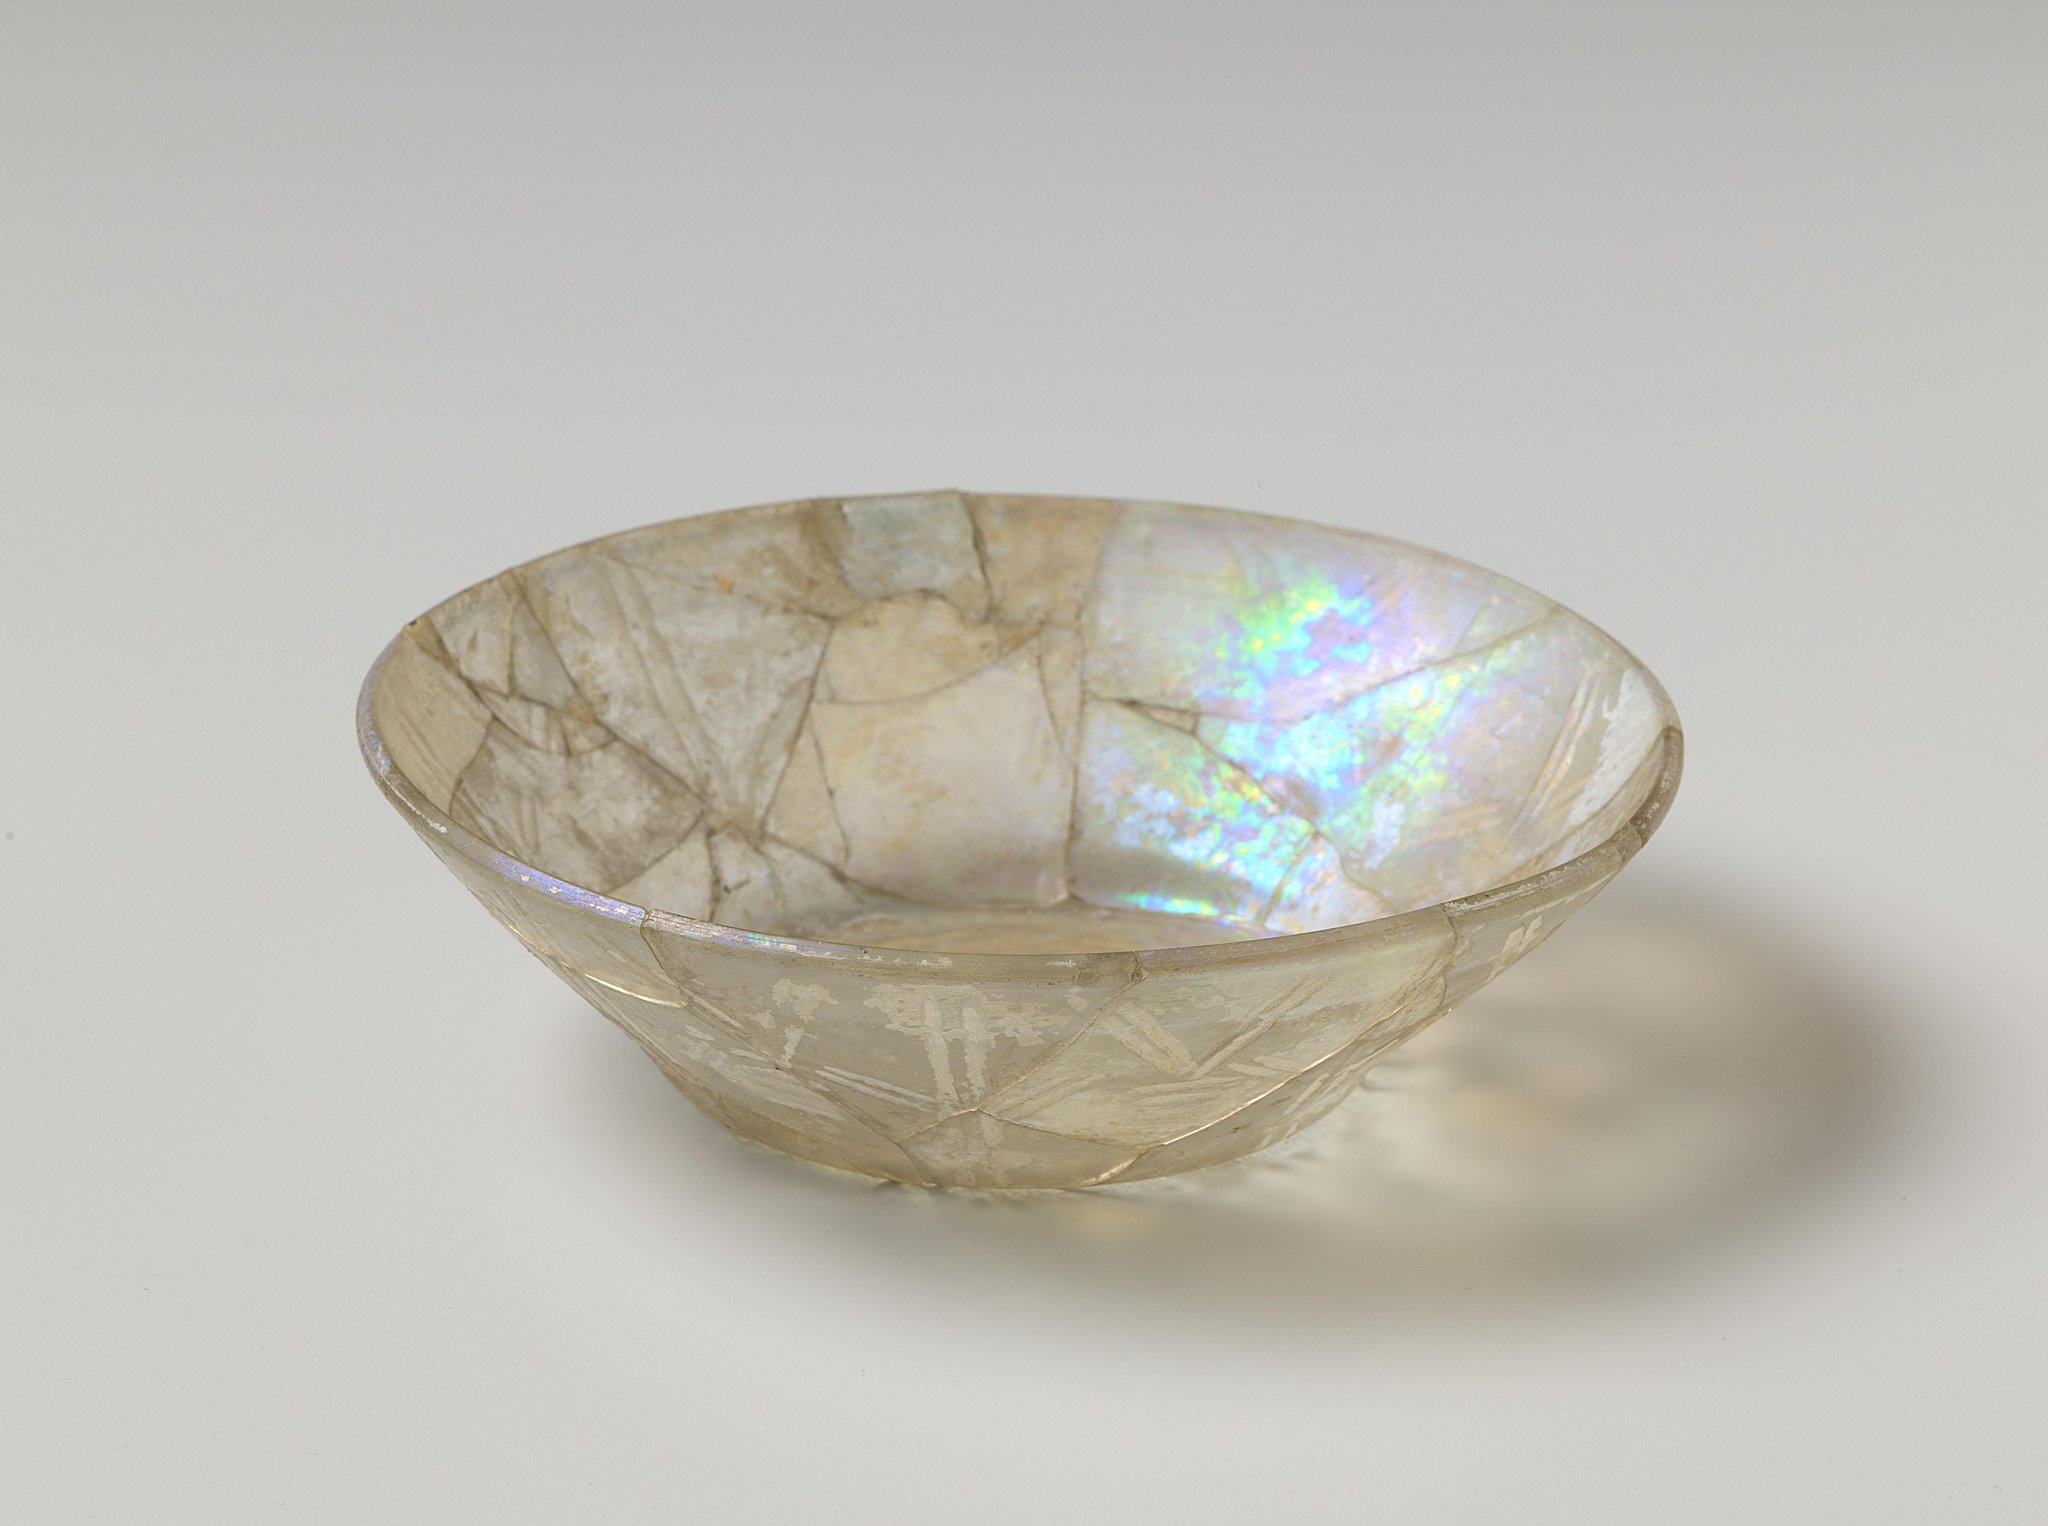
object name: bowl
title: Kom van glas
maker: Anonymous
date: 900-1100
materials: glass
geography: nishapur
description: Kom, concaaf, van doorschijnend, geïriseerd glas. Aan de buitenzijde gedecoreerd met in brede dubbele lijnen ingekraste eenvoudige patronen. (gebroken en gelijmd). Volgt de vorm van een aardewerken kom.